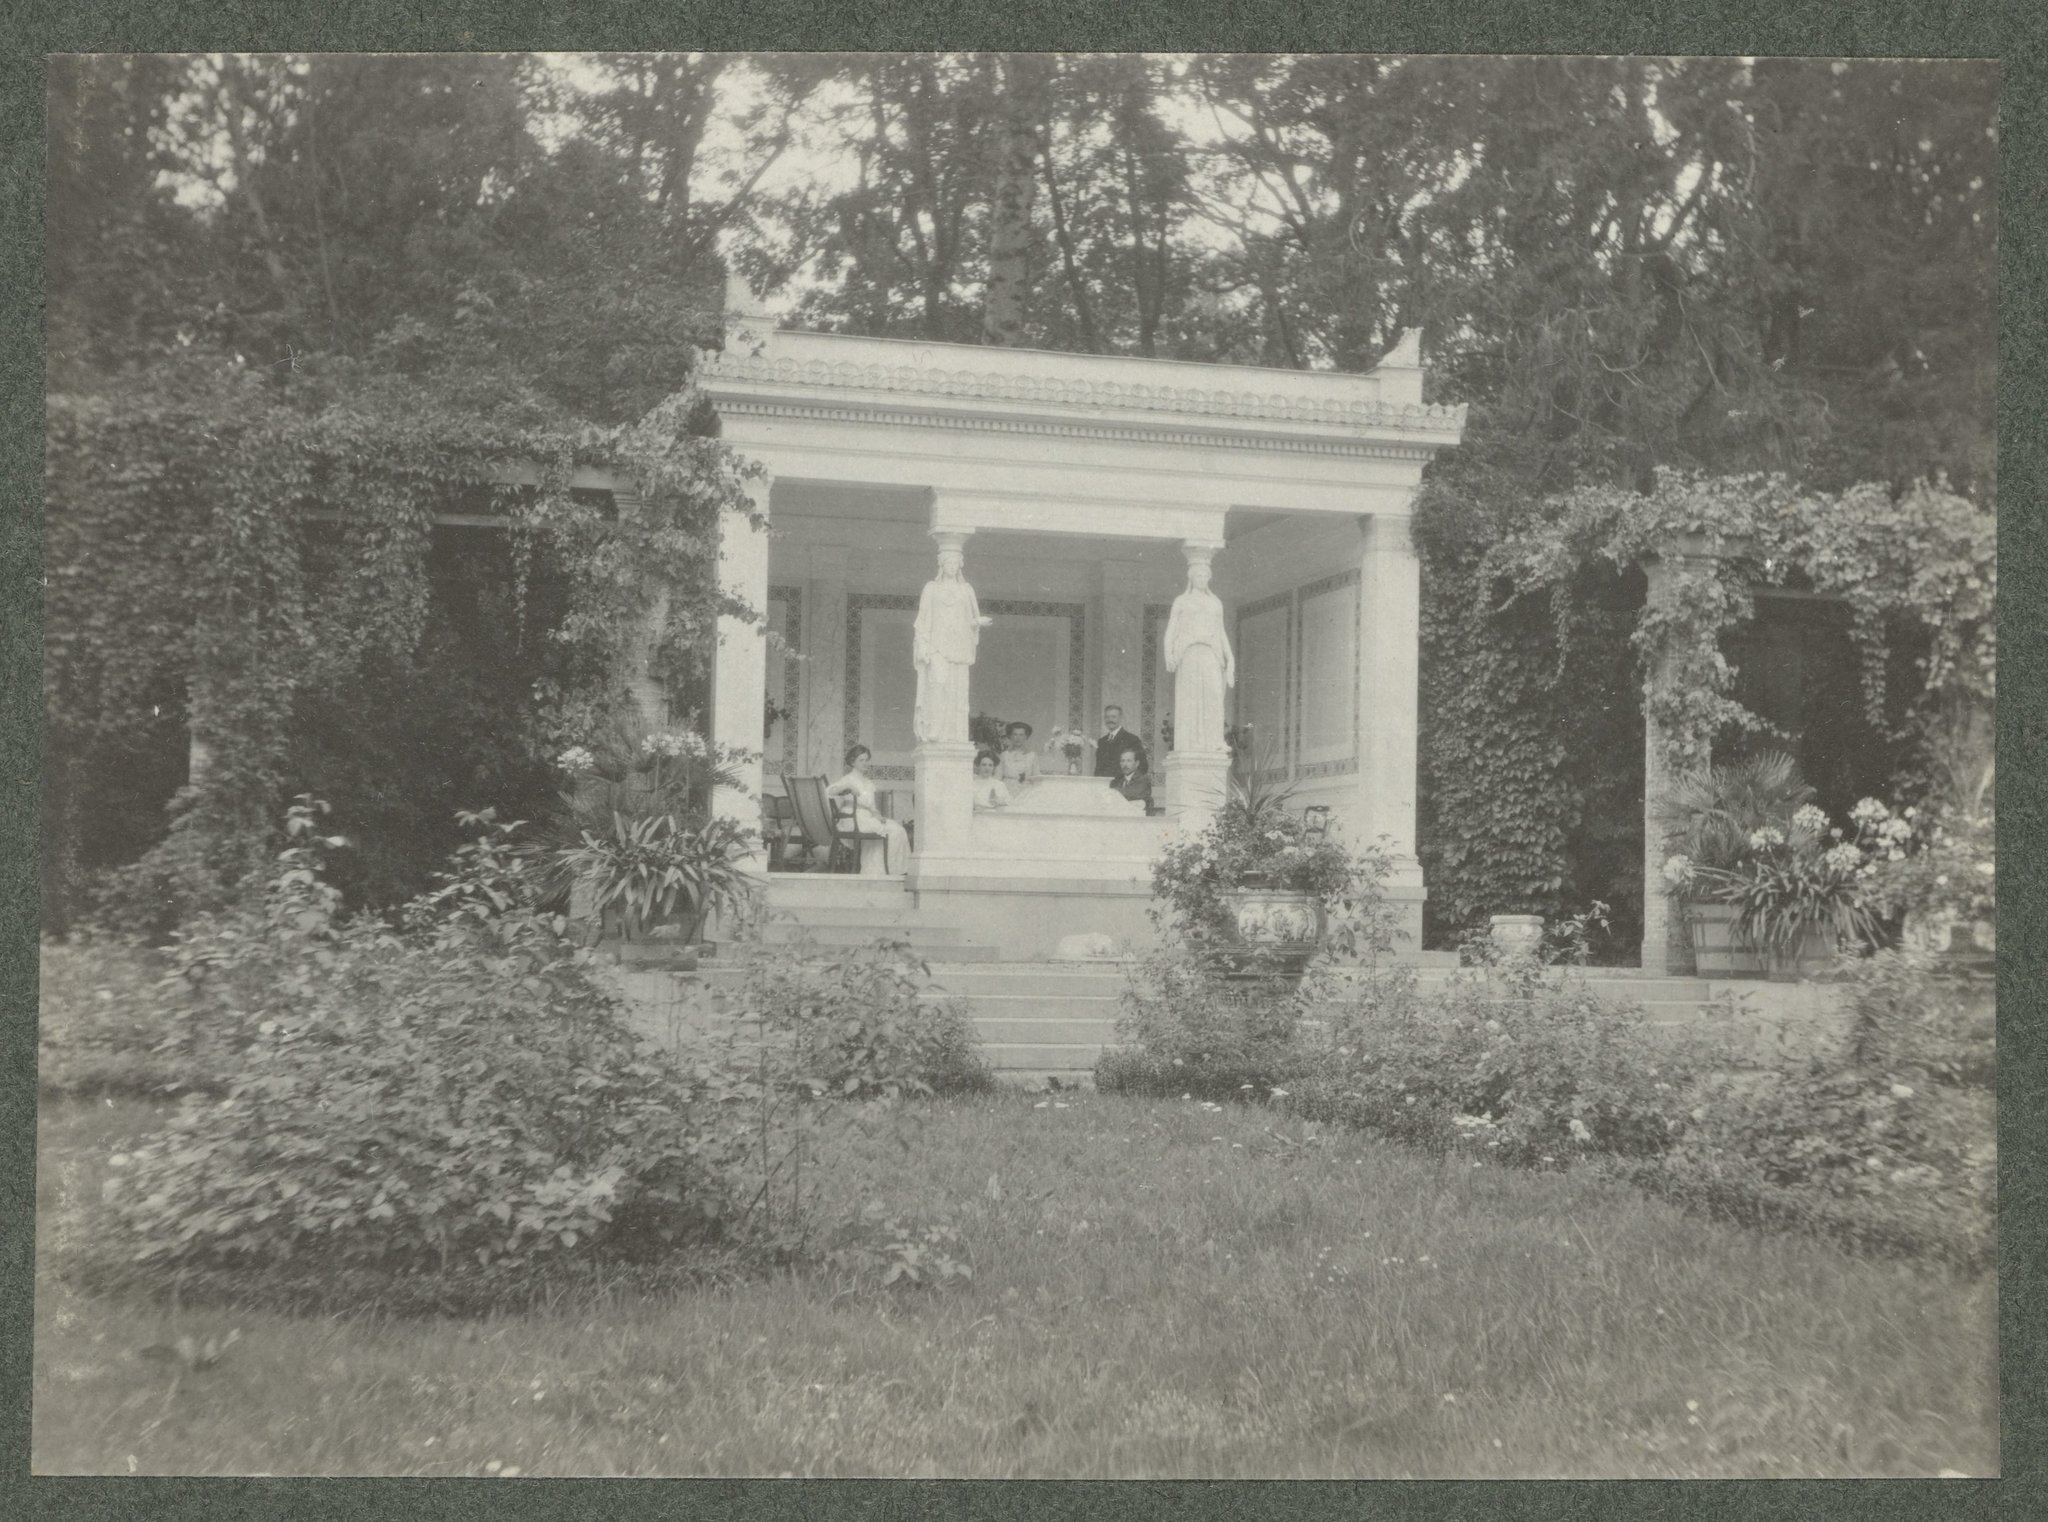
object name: photograph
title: Overdekt theehuis met mensen, in de tuin van Landgoed De Paauw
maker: geldolph adriaan kessler (dolph)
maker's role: fotograaf, industrieel, voetballer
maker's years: 1884-1945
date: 1913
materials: paper, photographic support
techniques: gelatin silver print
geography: netherlands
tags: huize de paauw